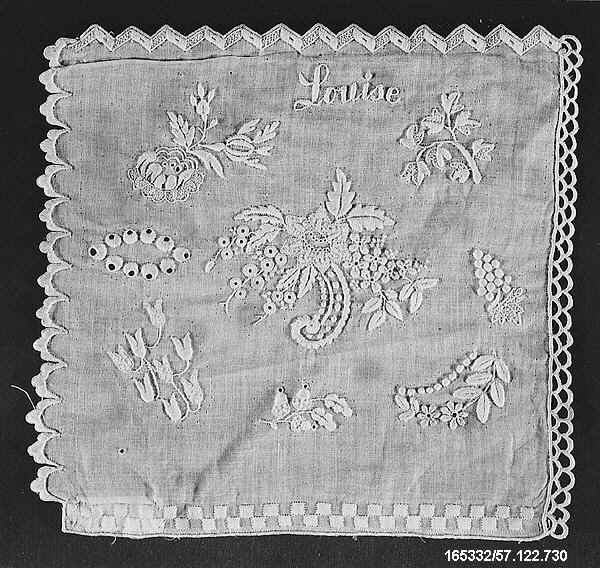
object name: sampler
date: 1801-1900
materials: cotton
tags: flowers